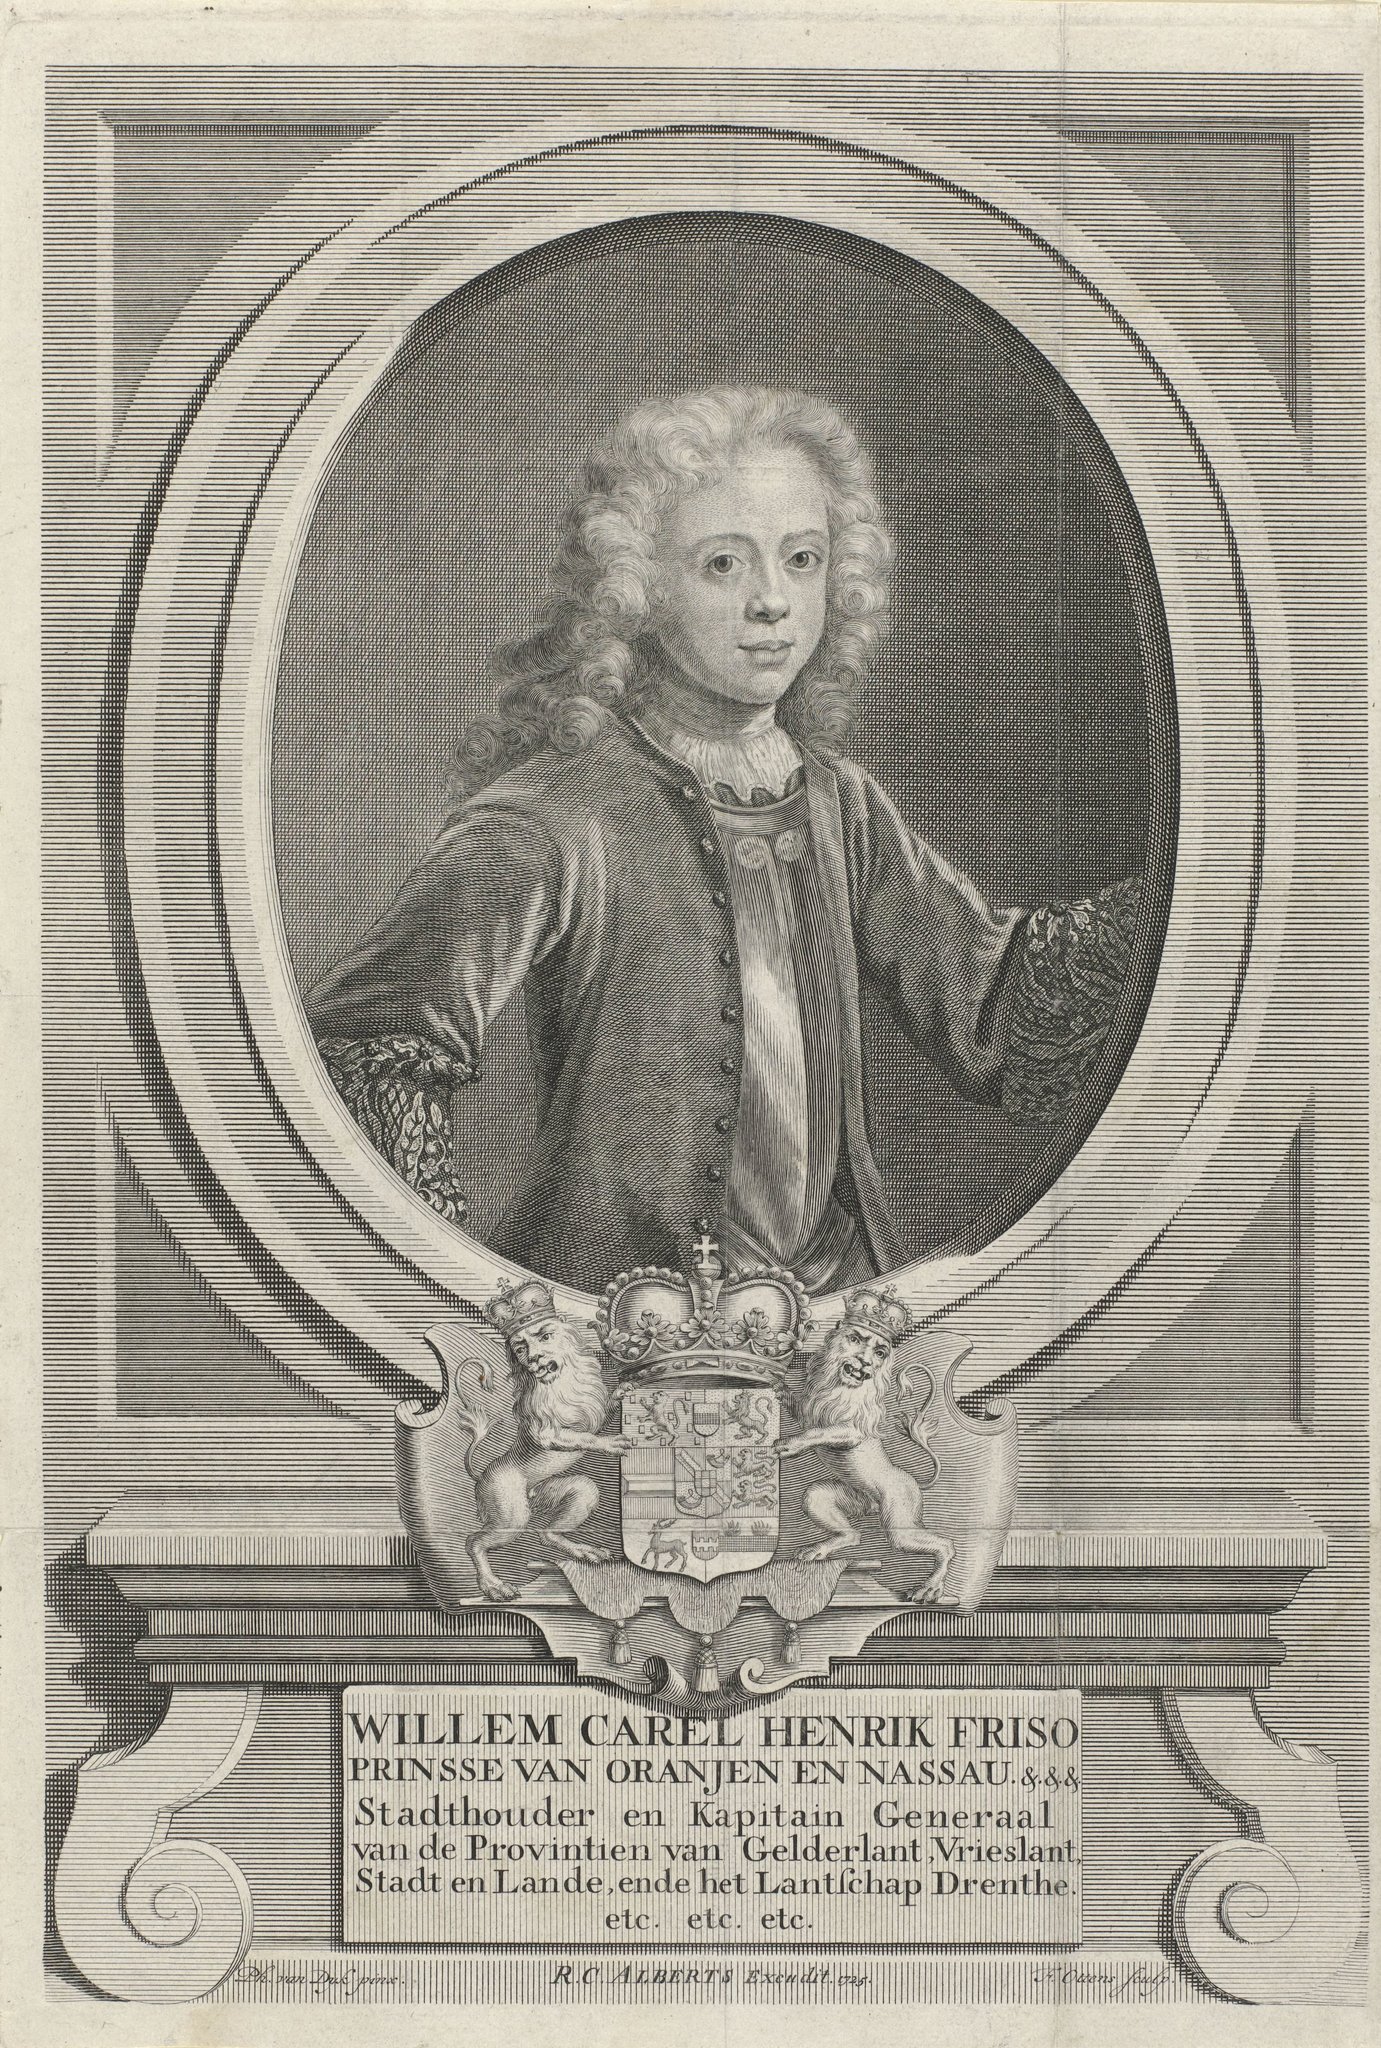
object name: print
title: Portret van Willem IV, prins van Oranje-Nassau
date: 1725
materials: paper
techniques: engraving, etching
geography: northern netherlands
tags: the hague, willem iv (prins van oranje-nassau)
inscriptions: date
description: De hier vermelde titel verwijst naar de hoogst verkregen titel van de geportretteerde, niet per se naar de titel die de geportretteerde op deze voorstelling draagt.